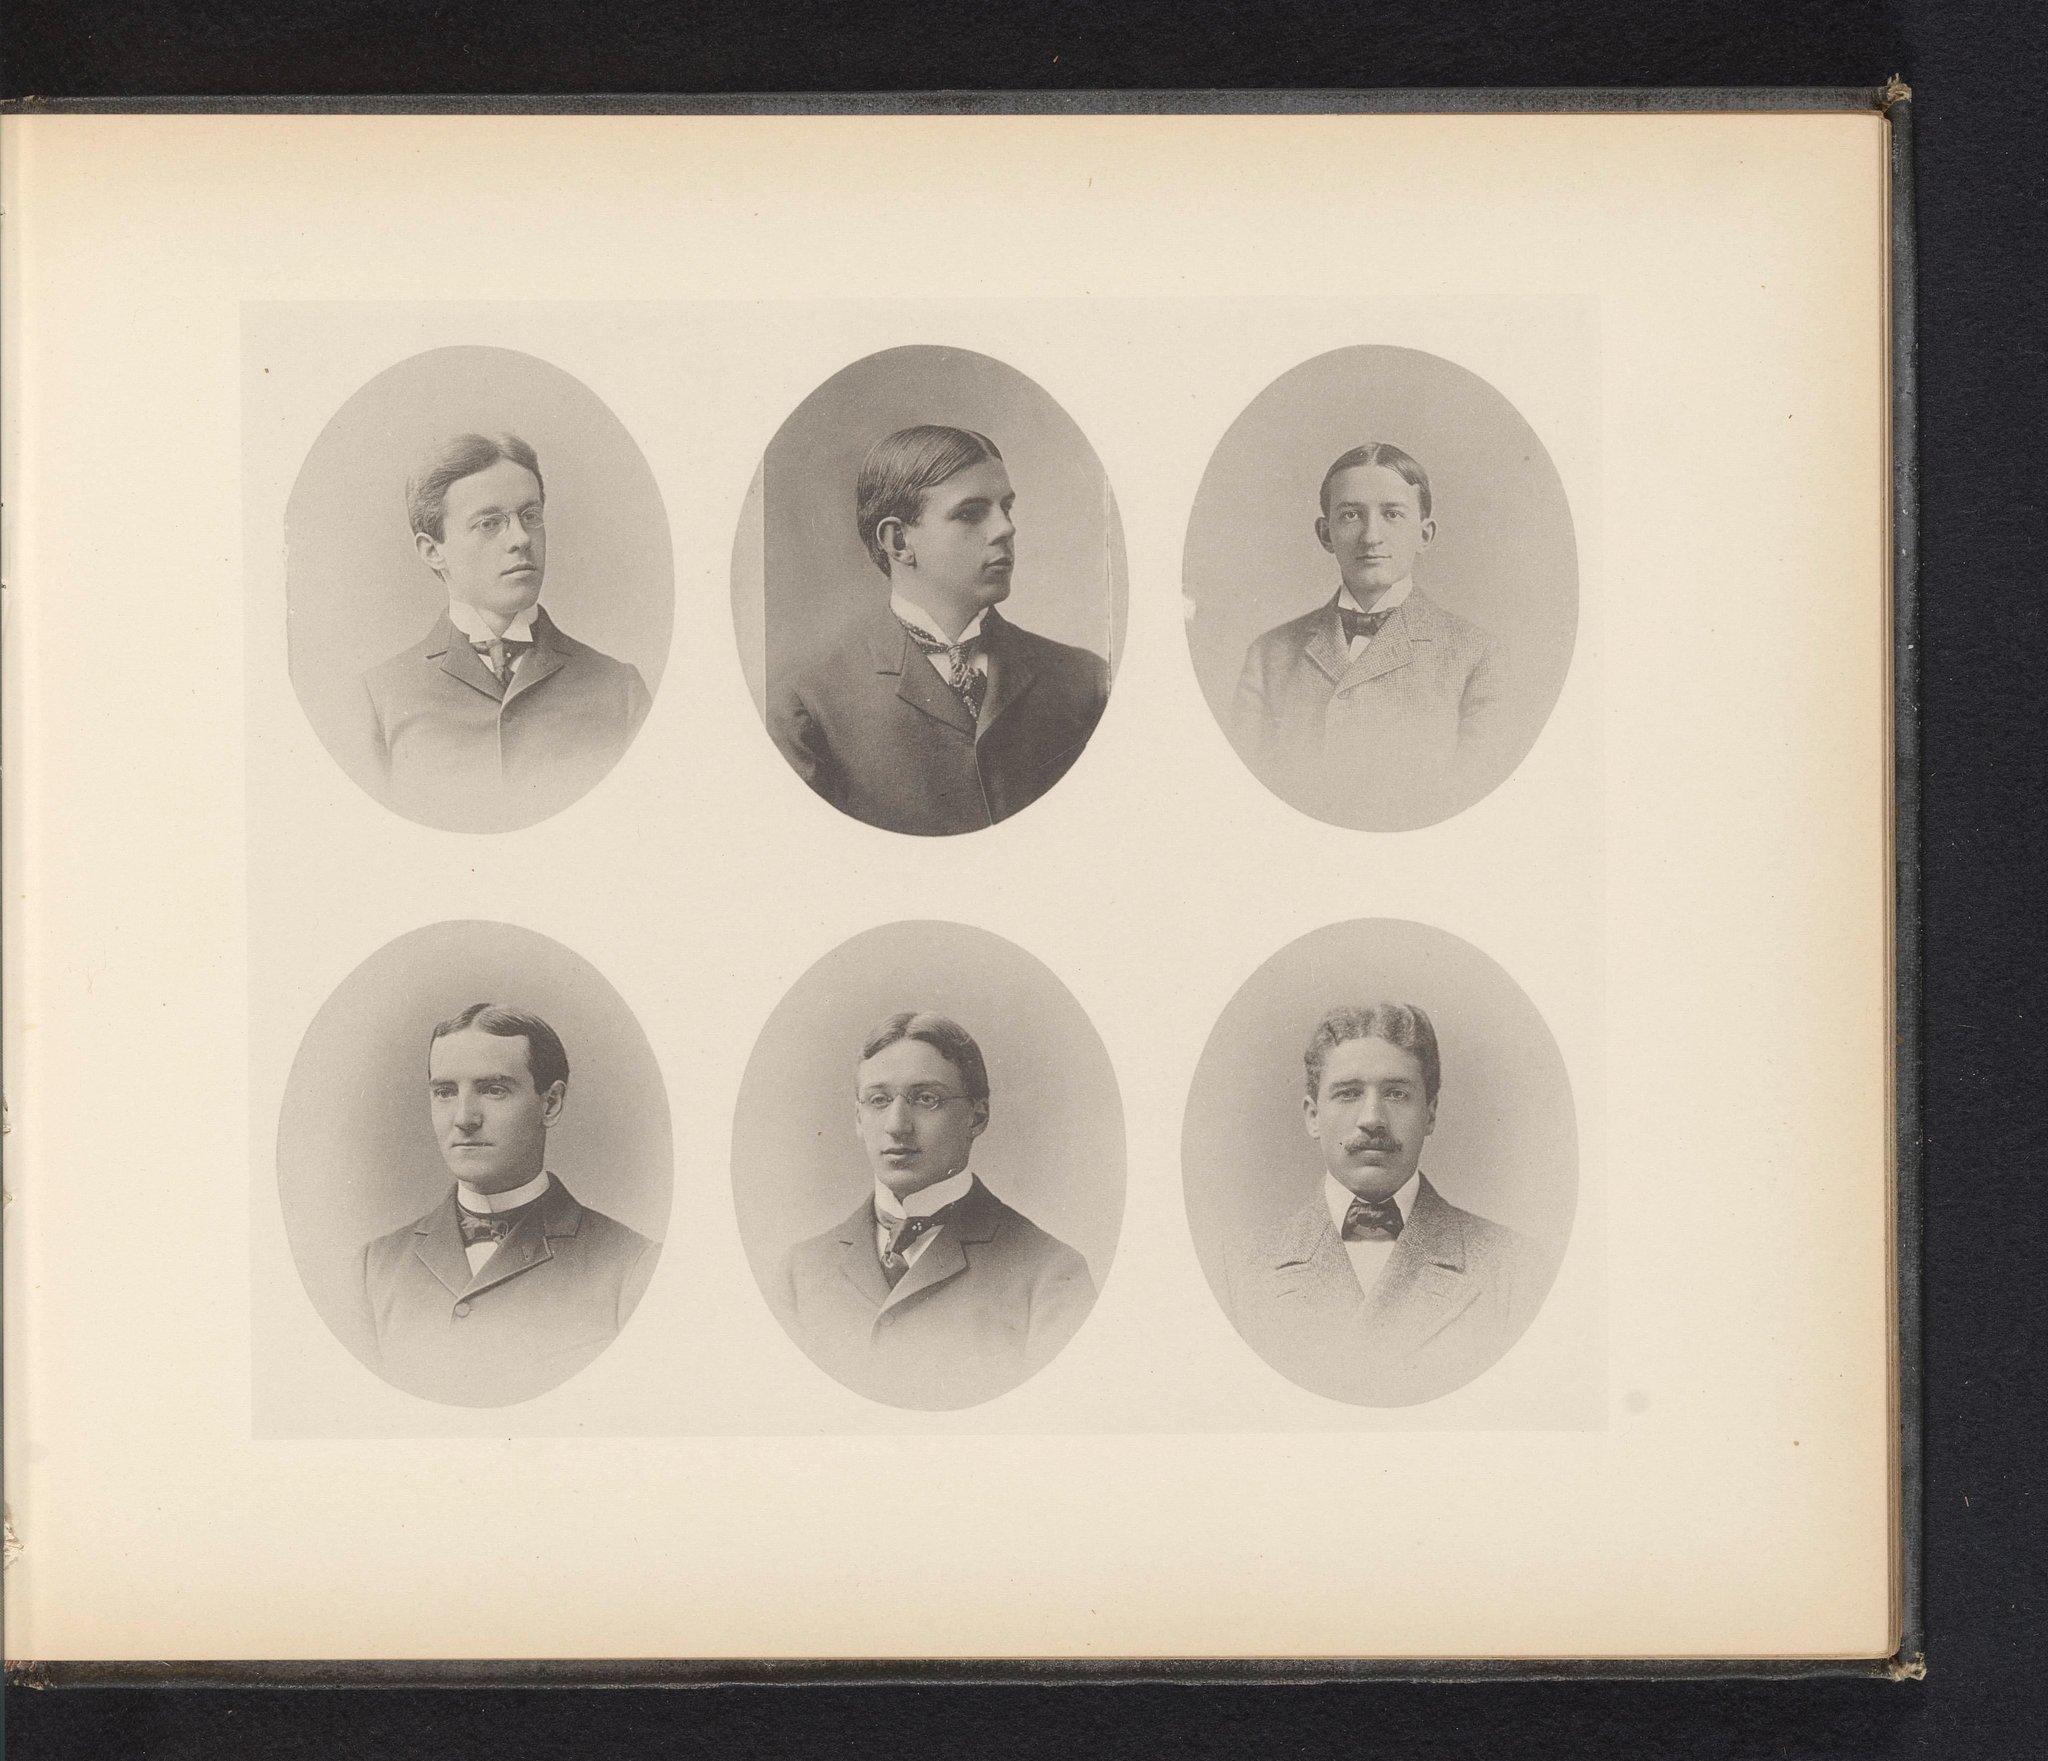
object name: page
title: Zes portretten van afgestudeerde studenten van Yale University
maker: Anonymous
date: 1895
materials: paper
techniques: photograph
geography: new york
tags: student